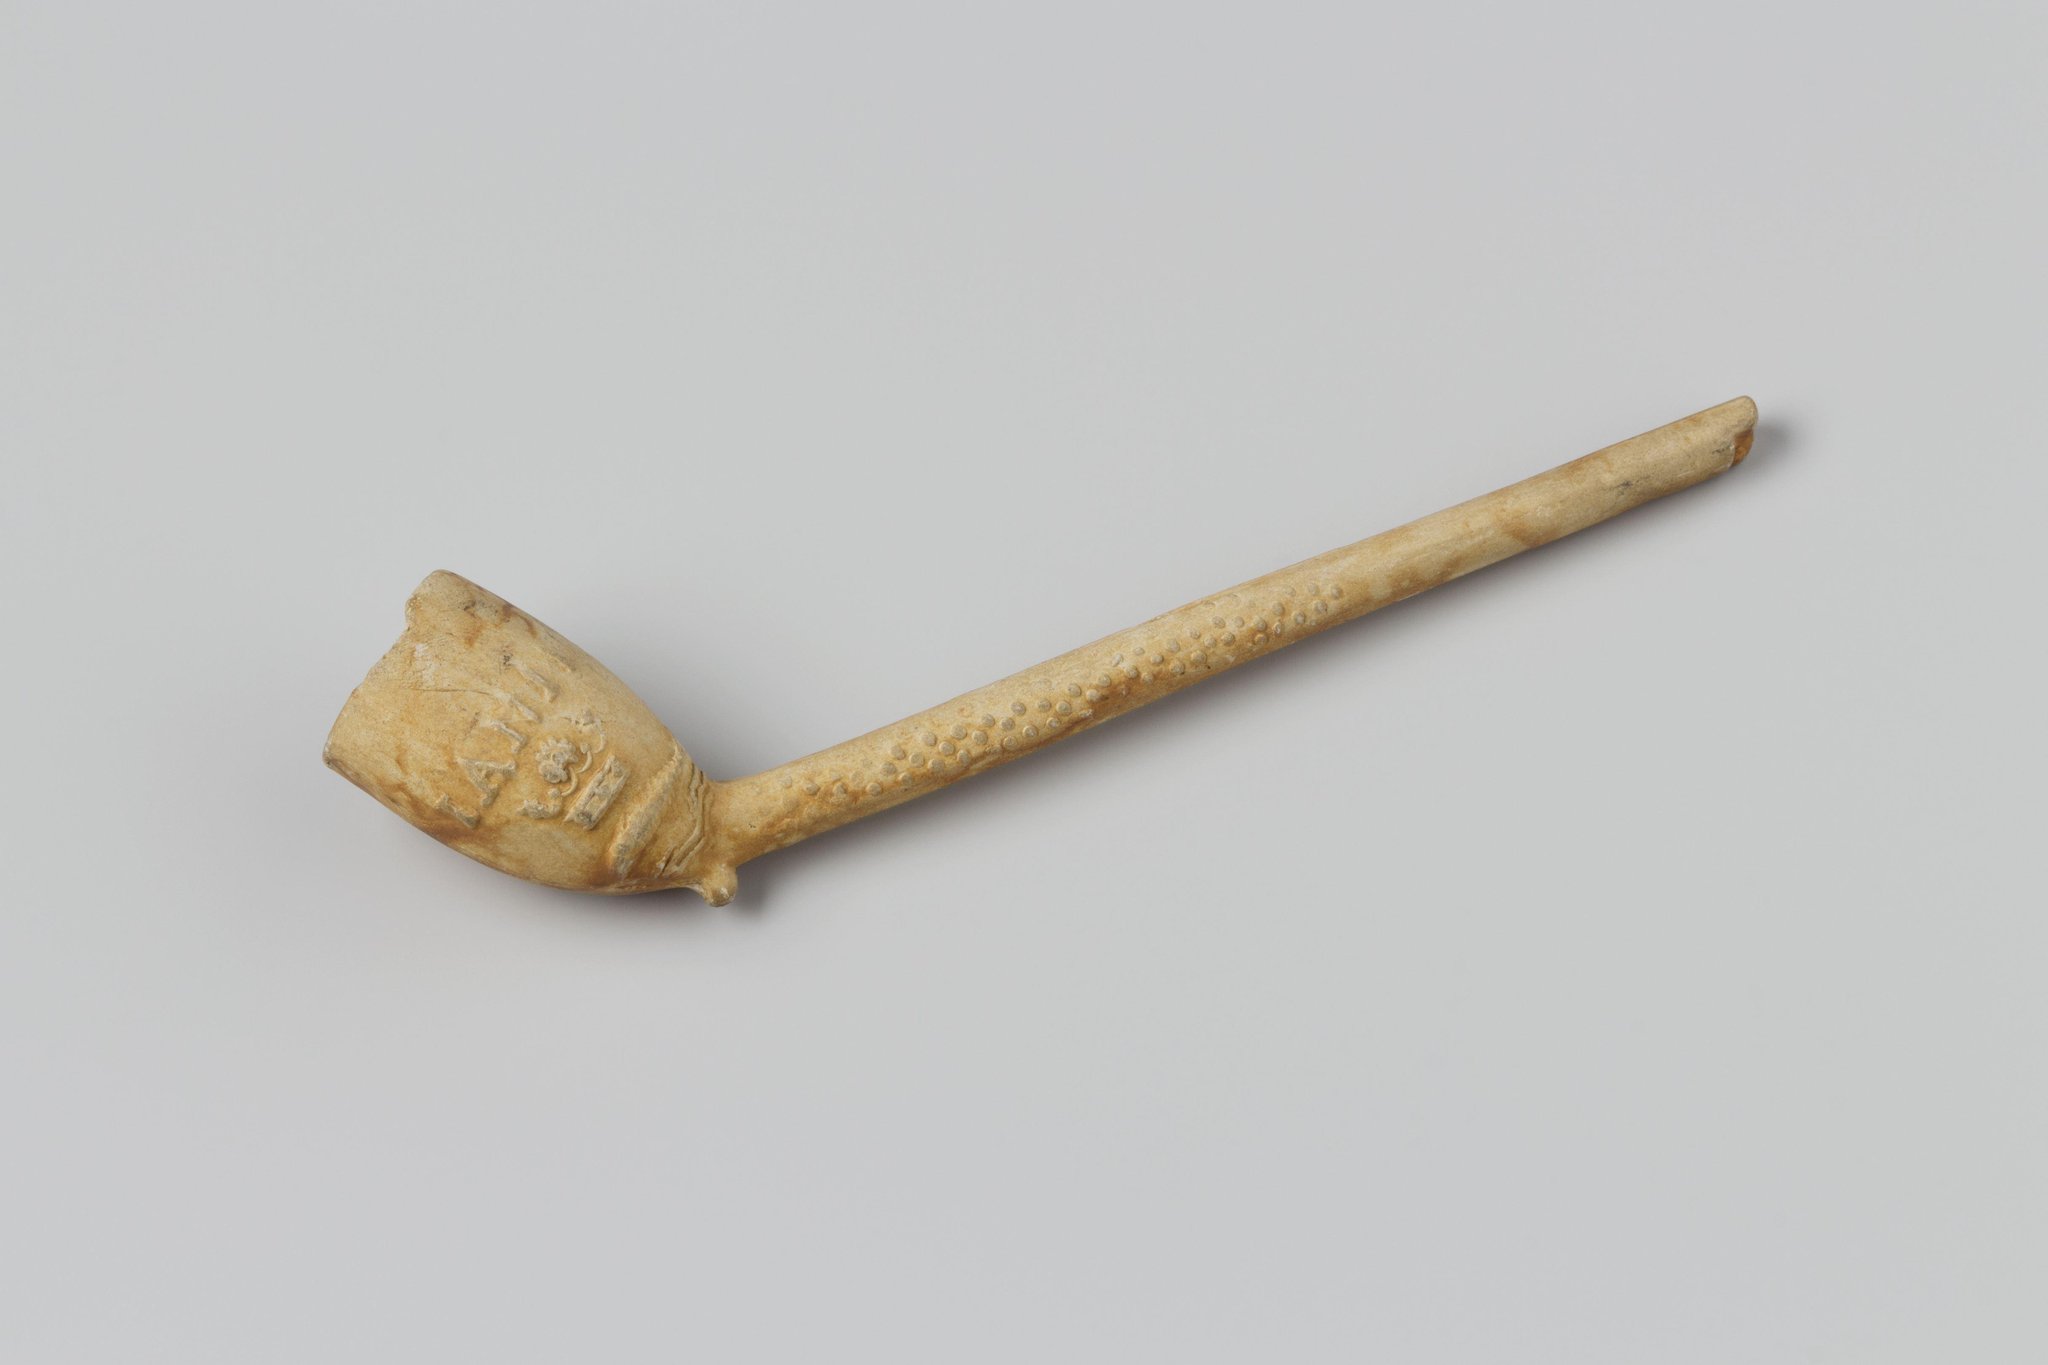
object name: tabakspijp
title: Tabakspijp.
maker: Anonymous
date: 1400-1950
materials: earthenware, clay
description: Tabakspijp waarop in relief IANM waaronder een gekroonde vis. Op de steel bolletjes en relief.